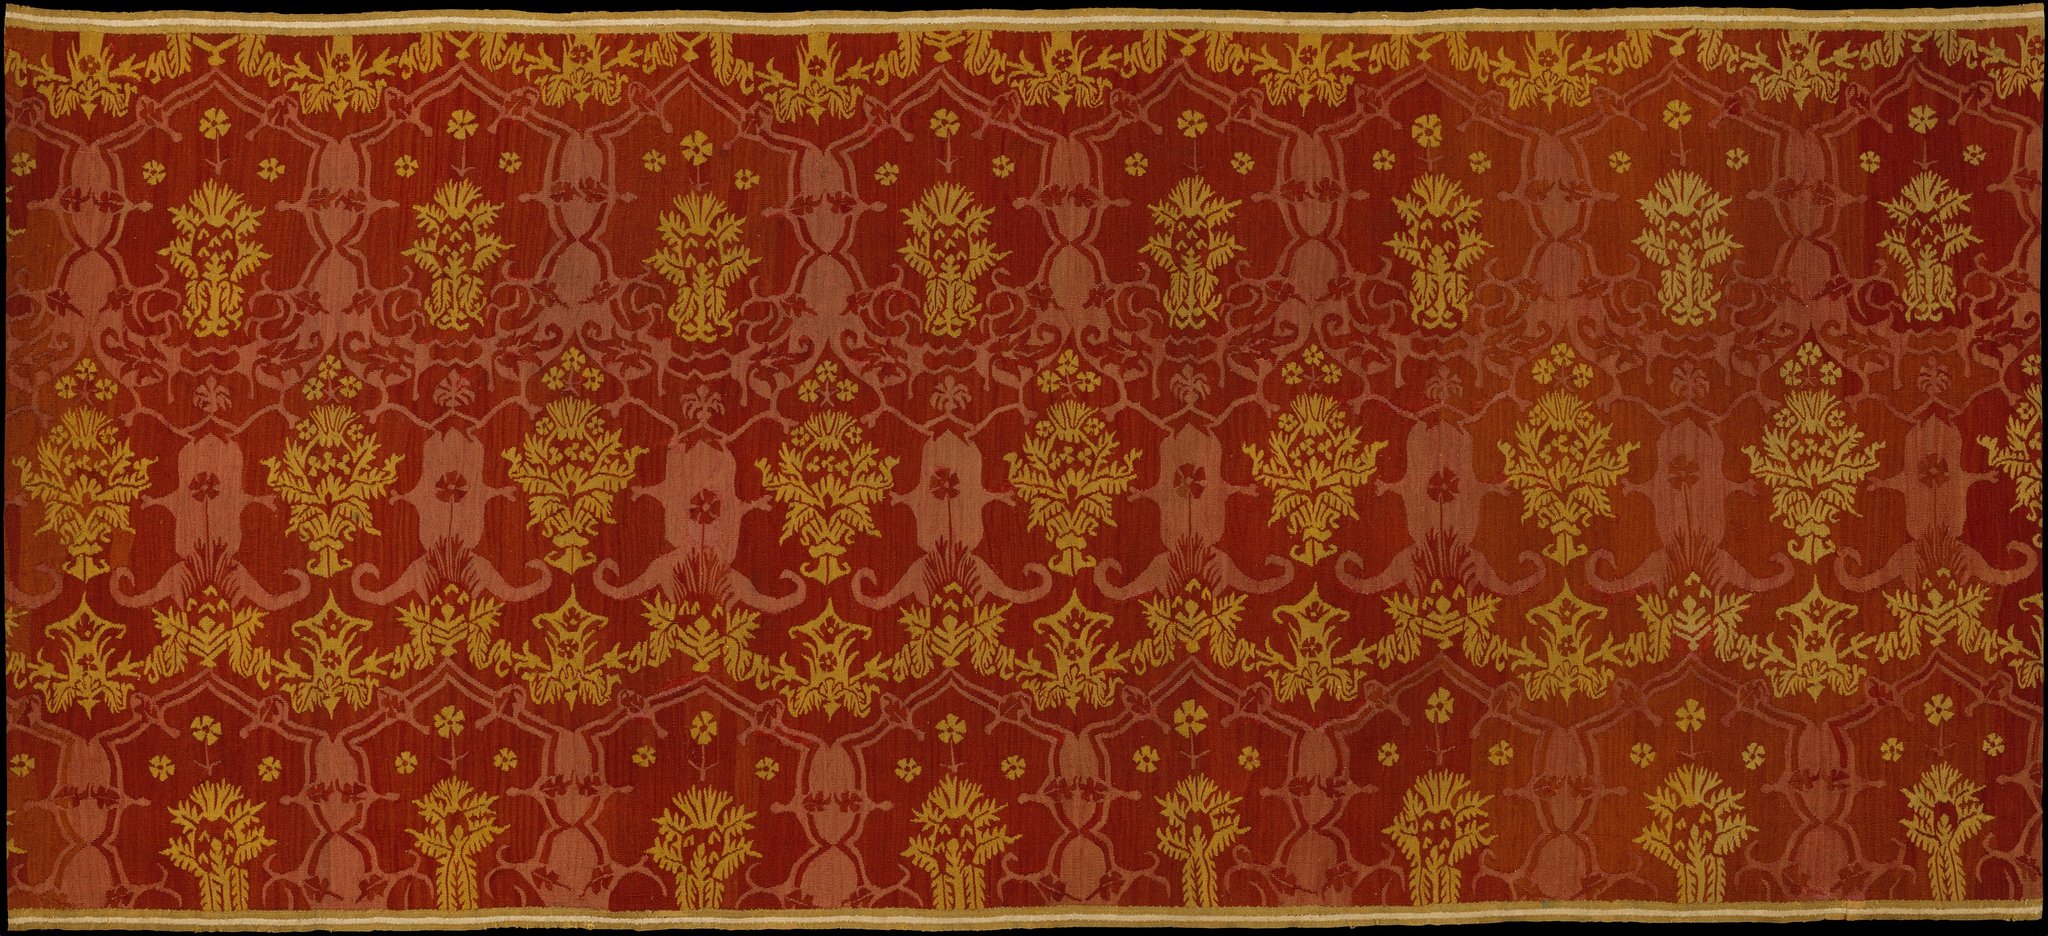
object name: tapestry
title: Hanging with a Simulated Silk Textile Pattern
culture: german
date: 1475-1520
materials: fiber, linen, wool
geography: germany